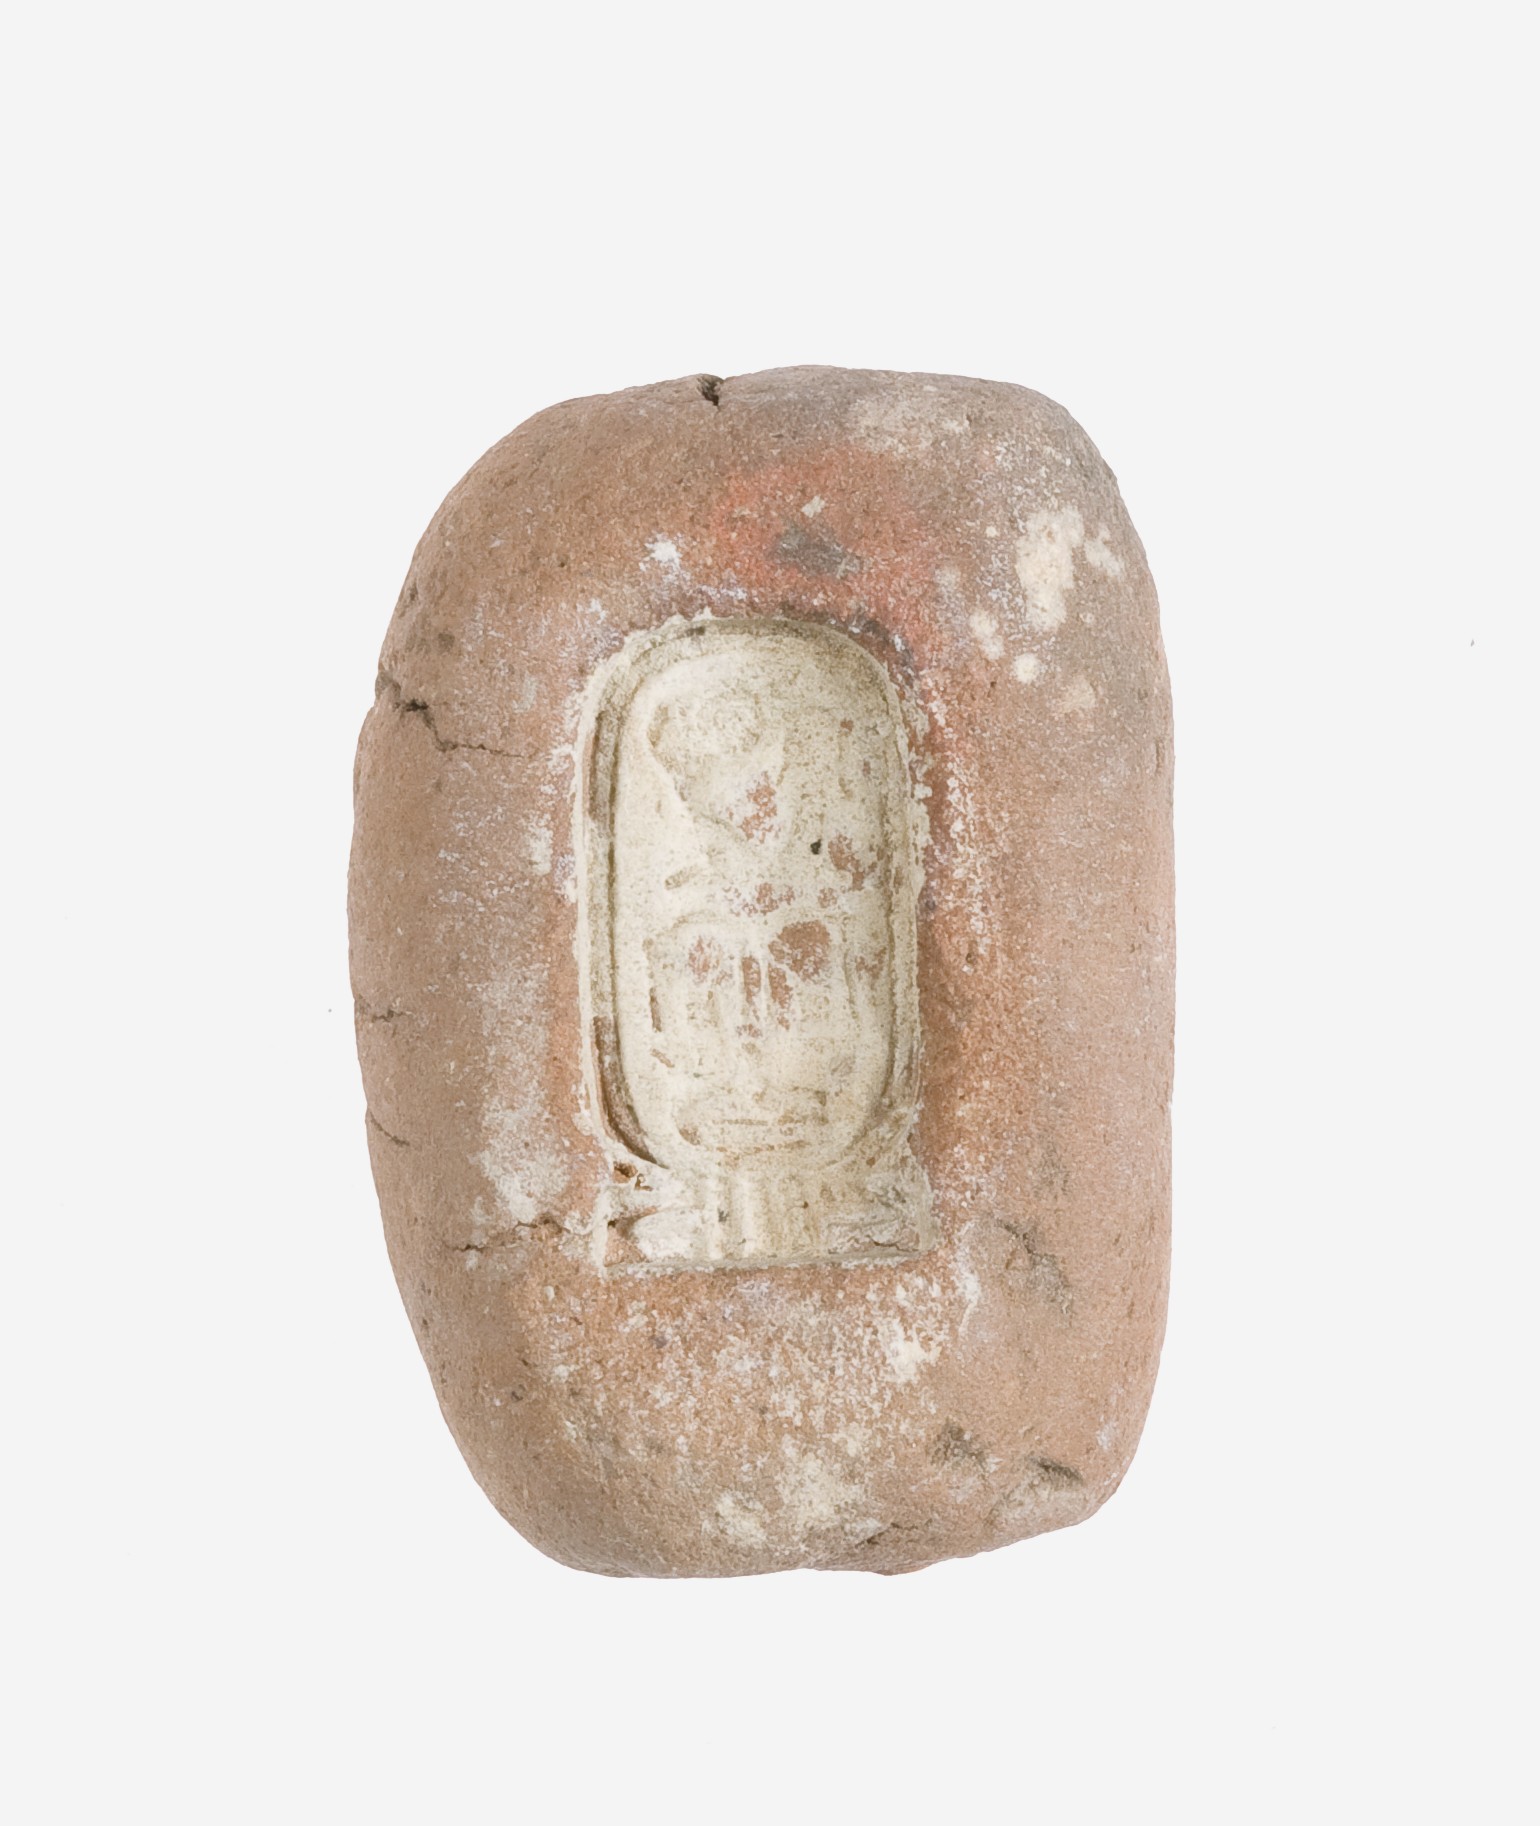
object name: mold, amulet, cartouche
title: Mold for a Cartouche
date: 1390-1352 BCE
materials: pottery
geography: egypt